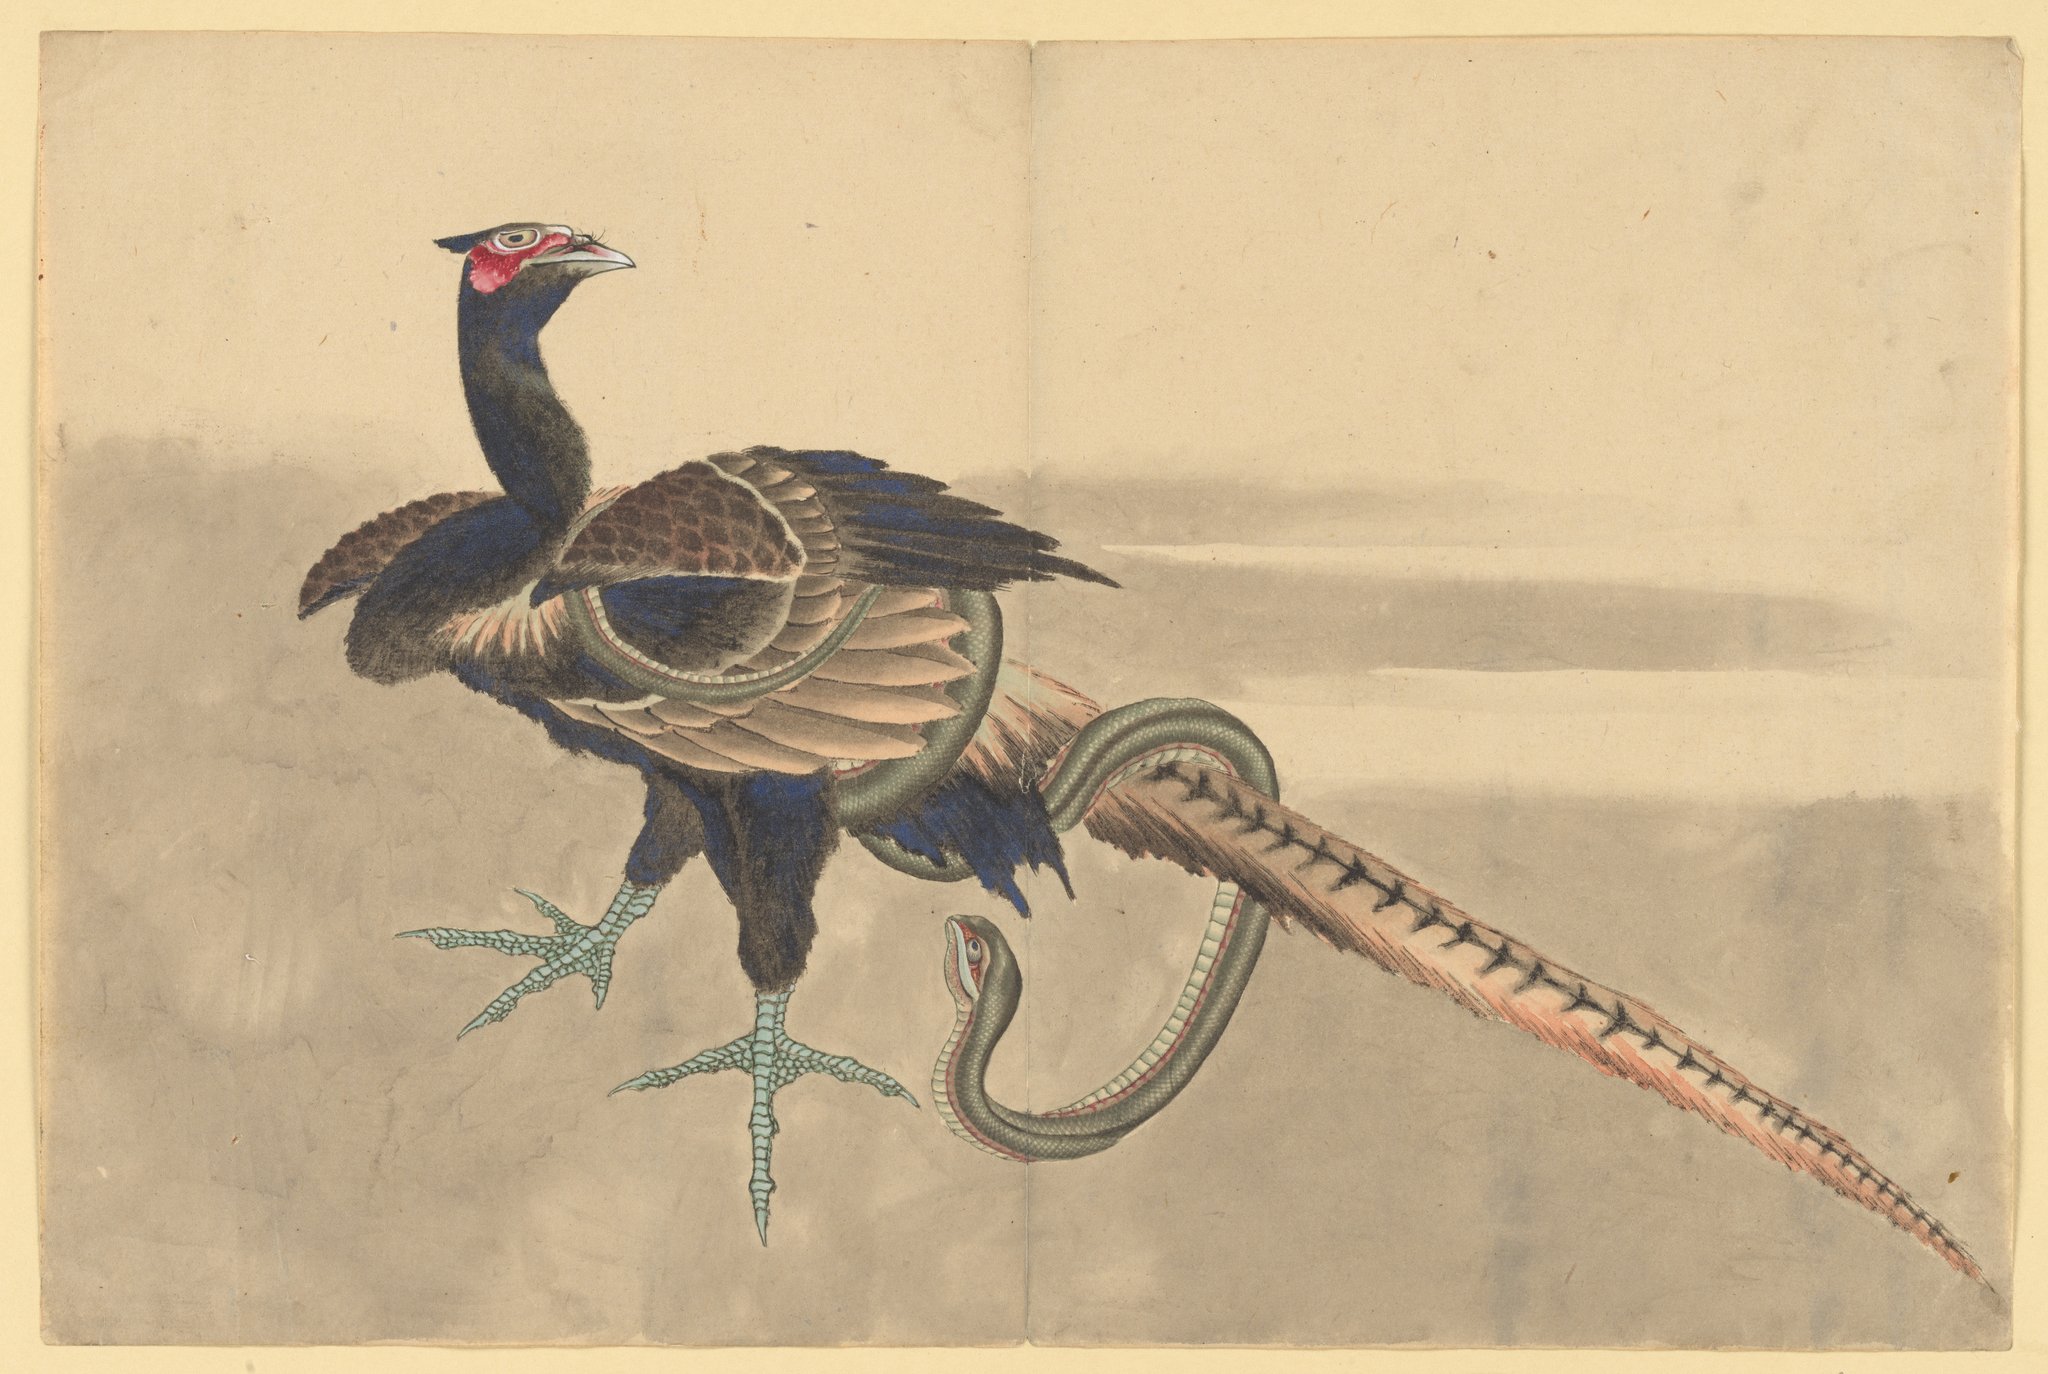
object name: drawing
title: Pheasant and Snake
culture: japanese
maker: katsushika hokusai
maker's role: artist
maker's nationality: japanese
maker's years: 1760-1849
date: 1701-1900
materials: ink, paper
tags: pheasants,snakes